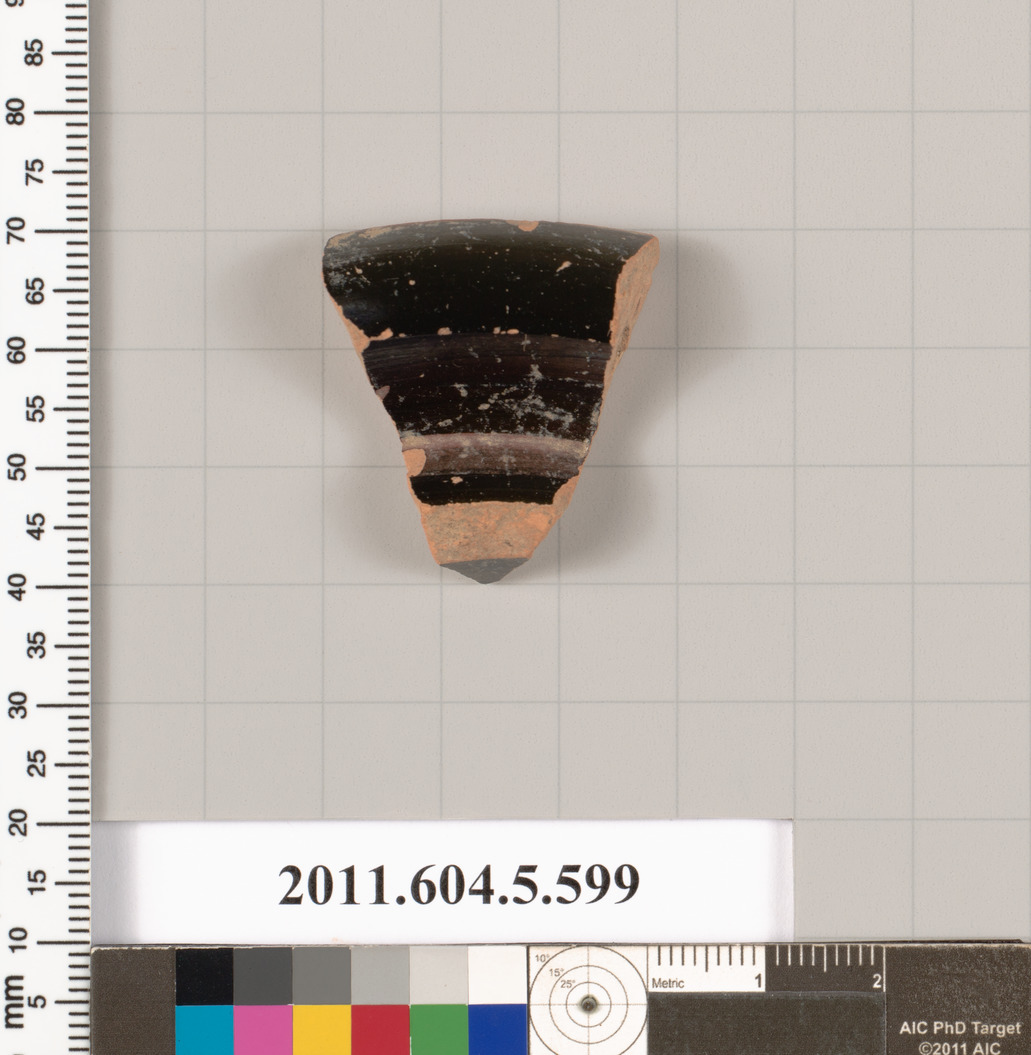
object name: stemless kylix fragment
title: Terracotta fragment of a stemless kylix (drinking cup)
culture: greek, attic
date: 600-401 BCE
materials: terracotta